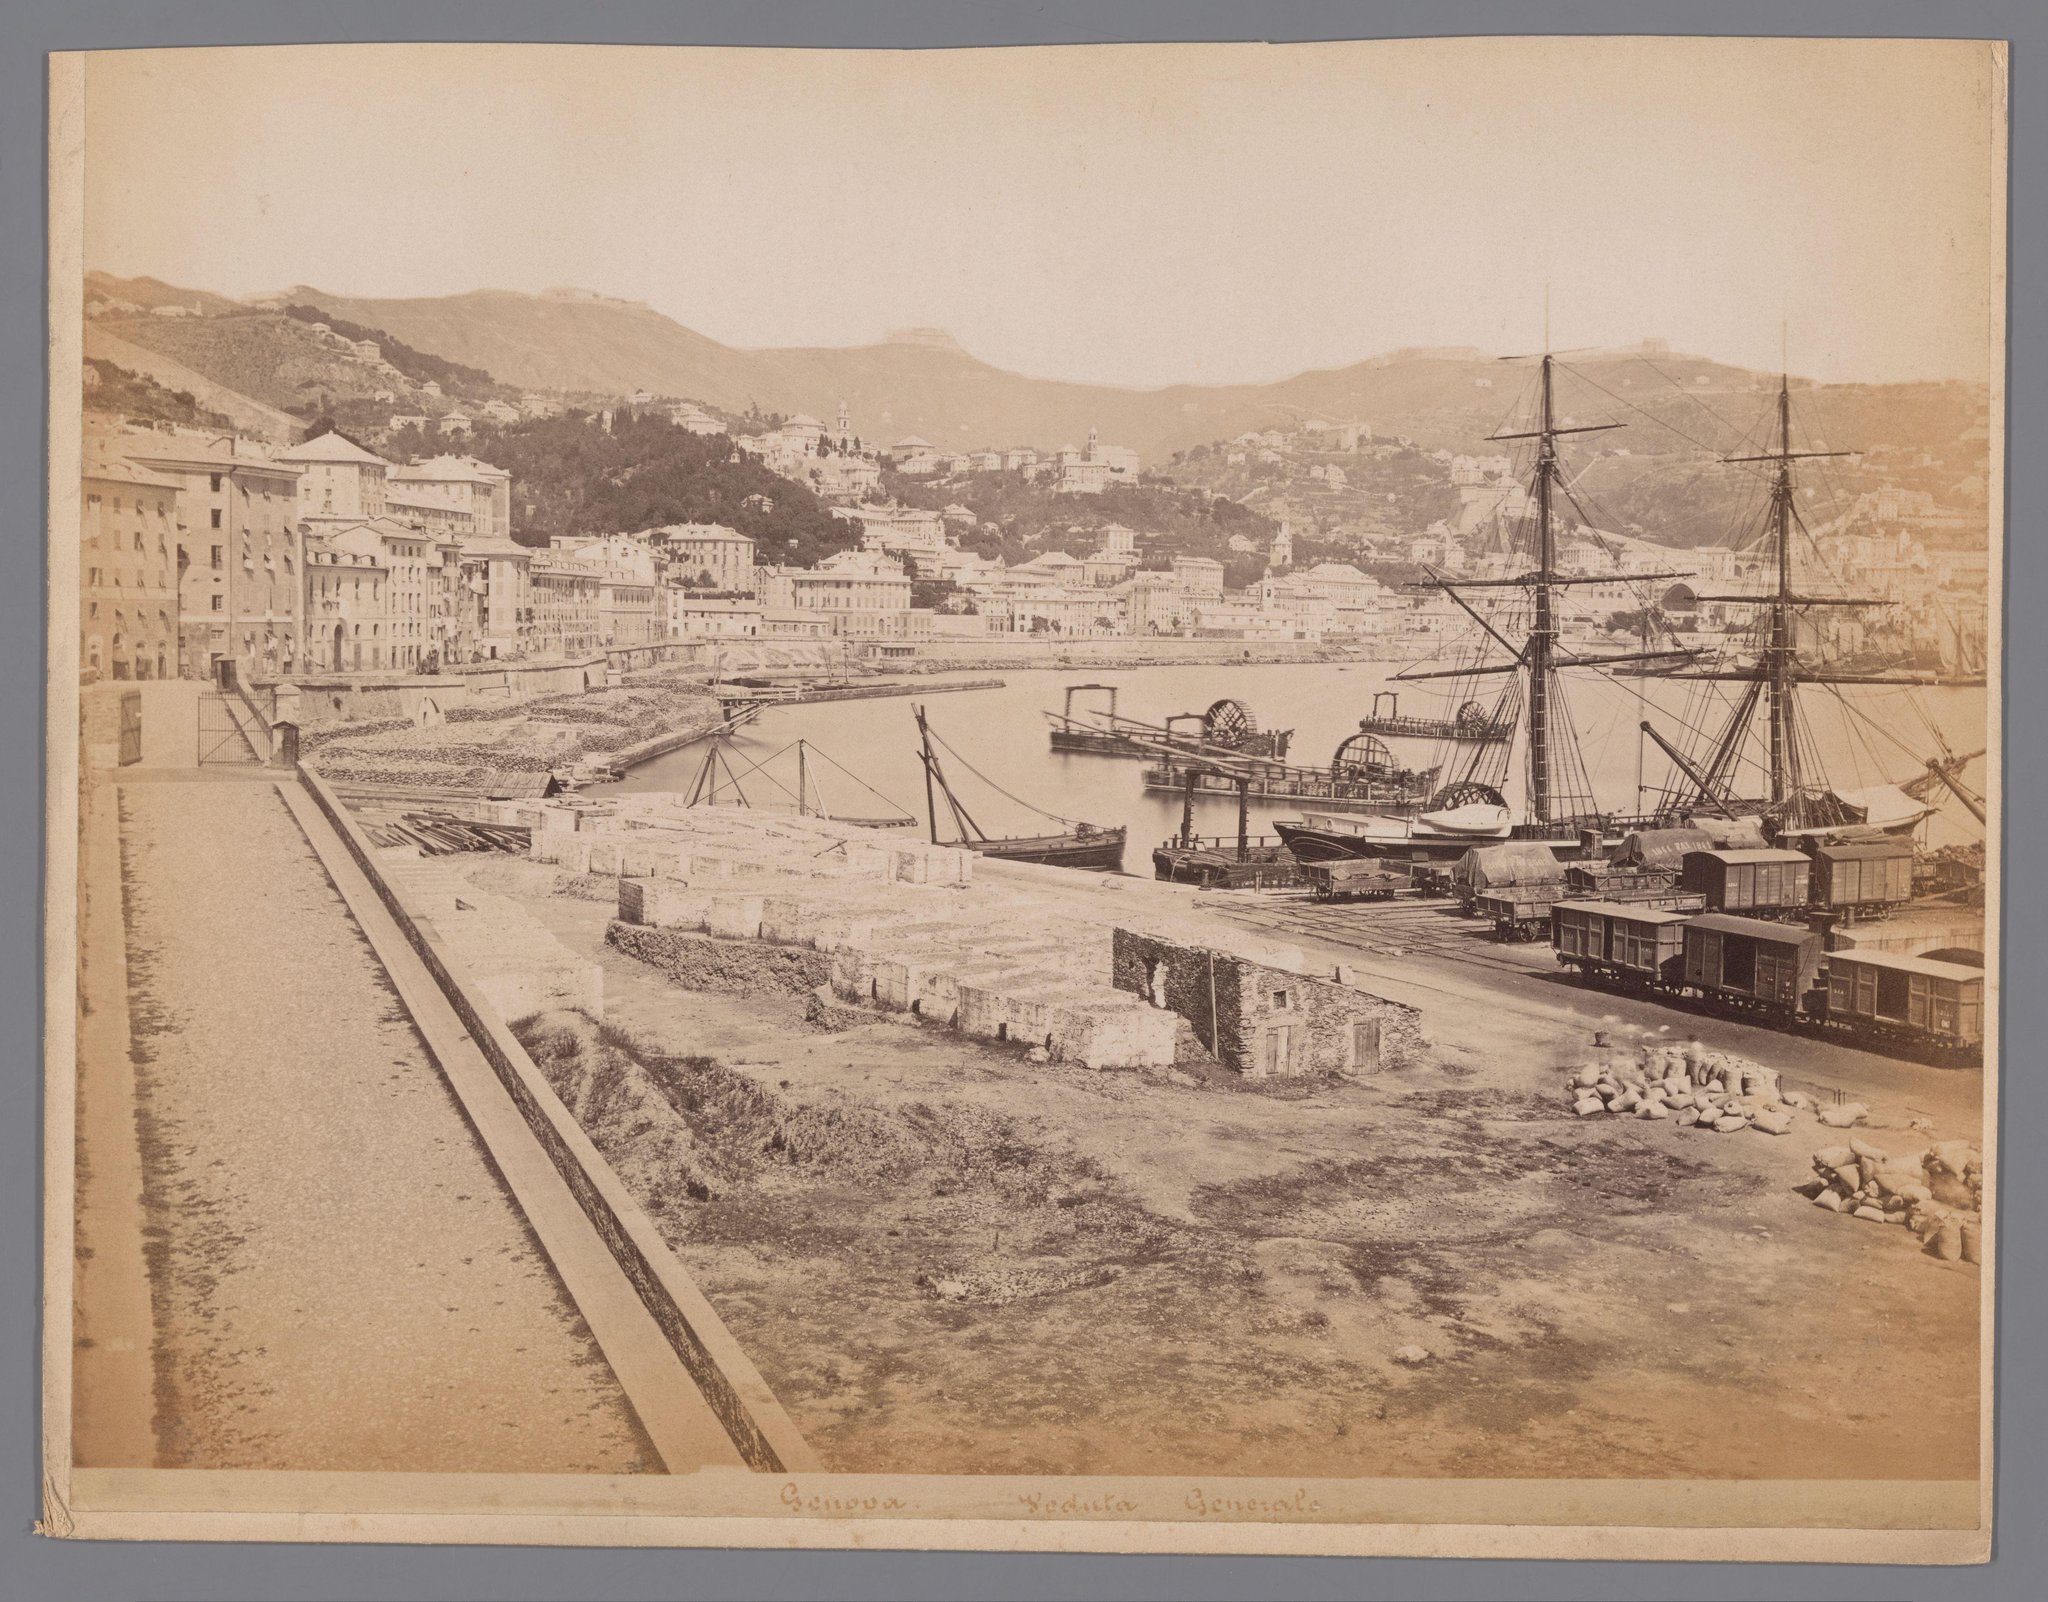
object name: photograph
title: Gezicht op de haven van Genua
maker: Anonymous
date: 1851-1900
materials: cardboard, paper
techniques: albumen print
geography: genoa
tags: harbour, city-view in general; 'veduta', mountains